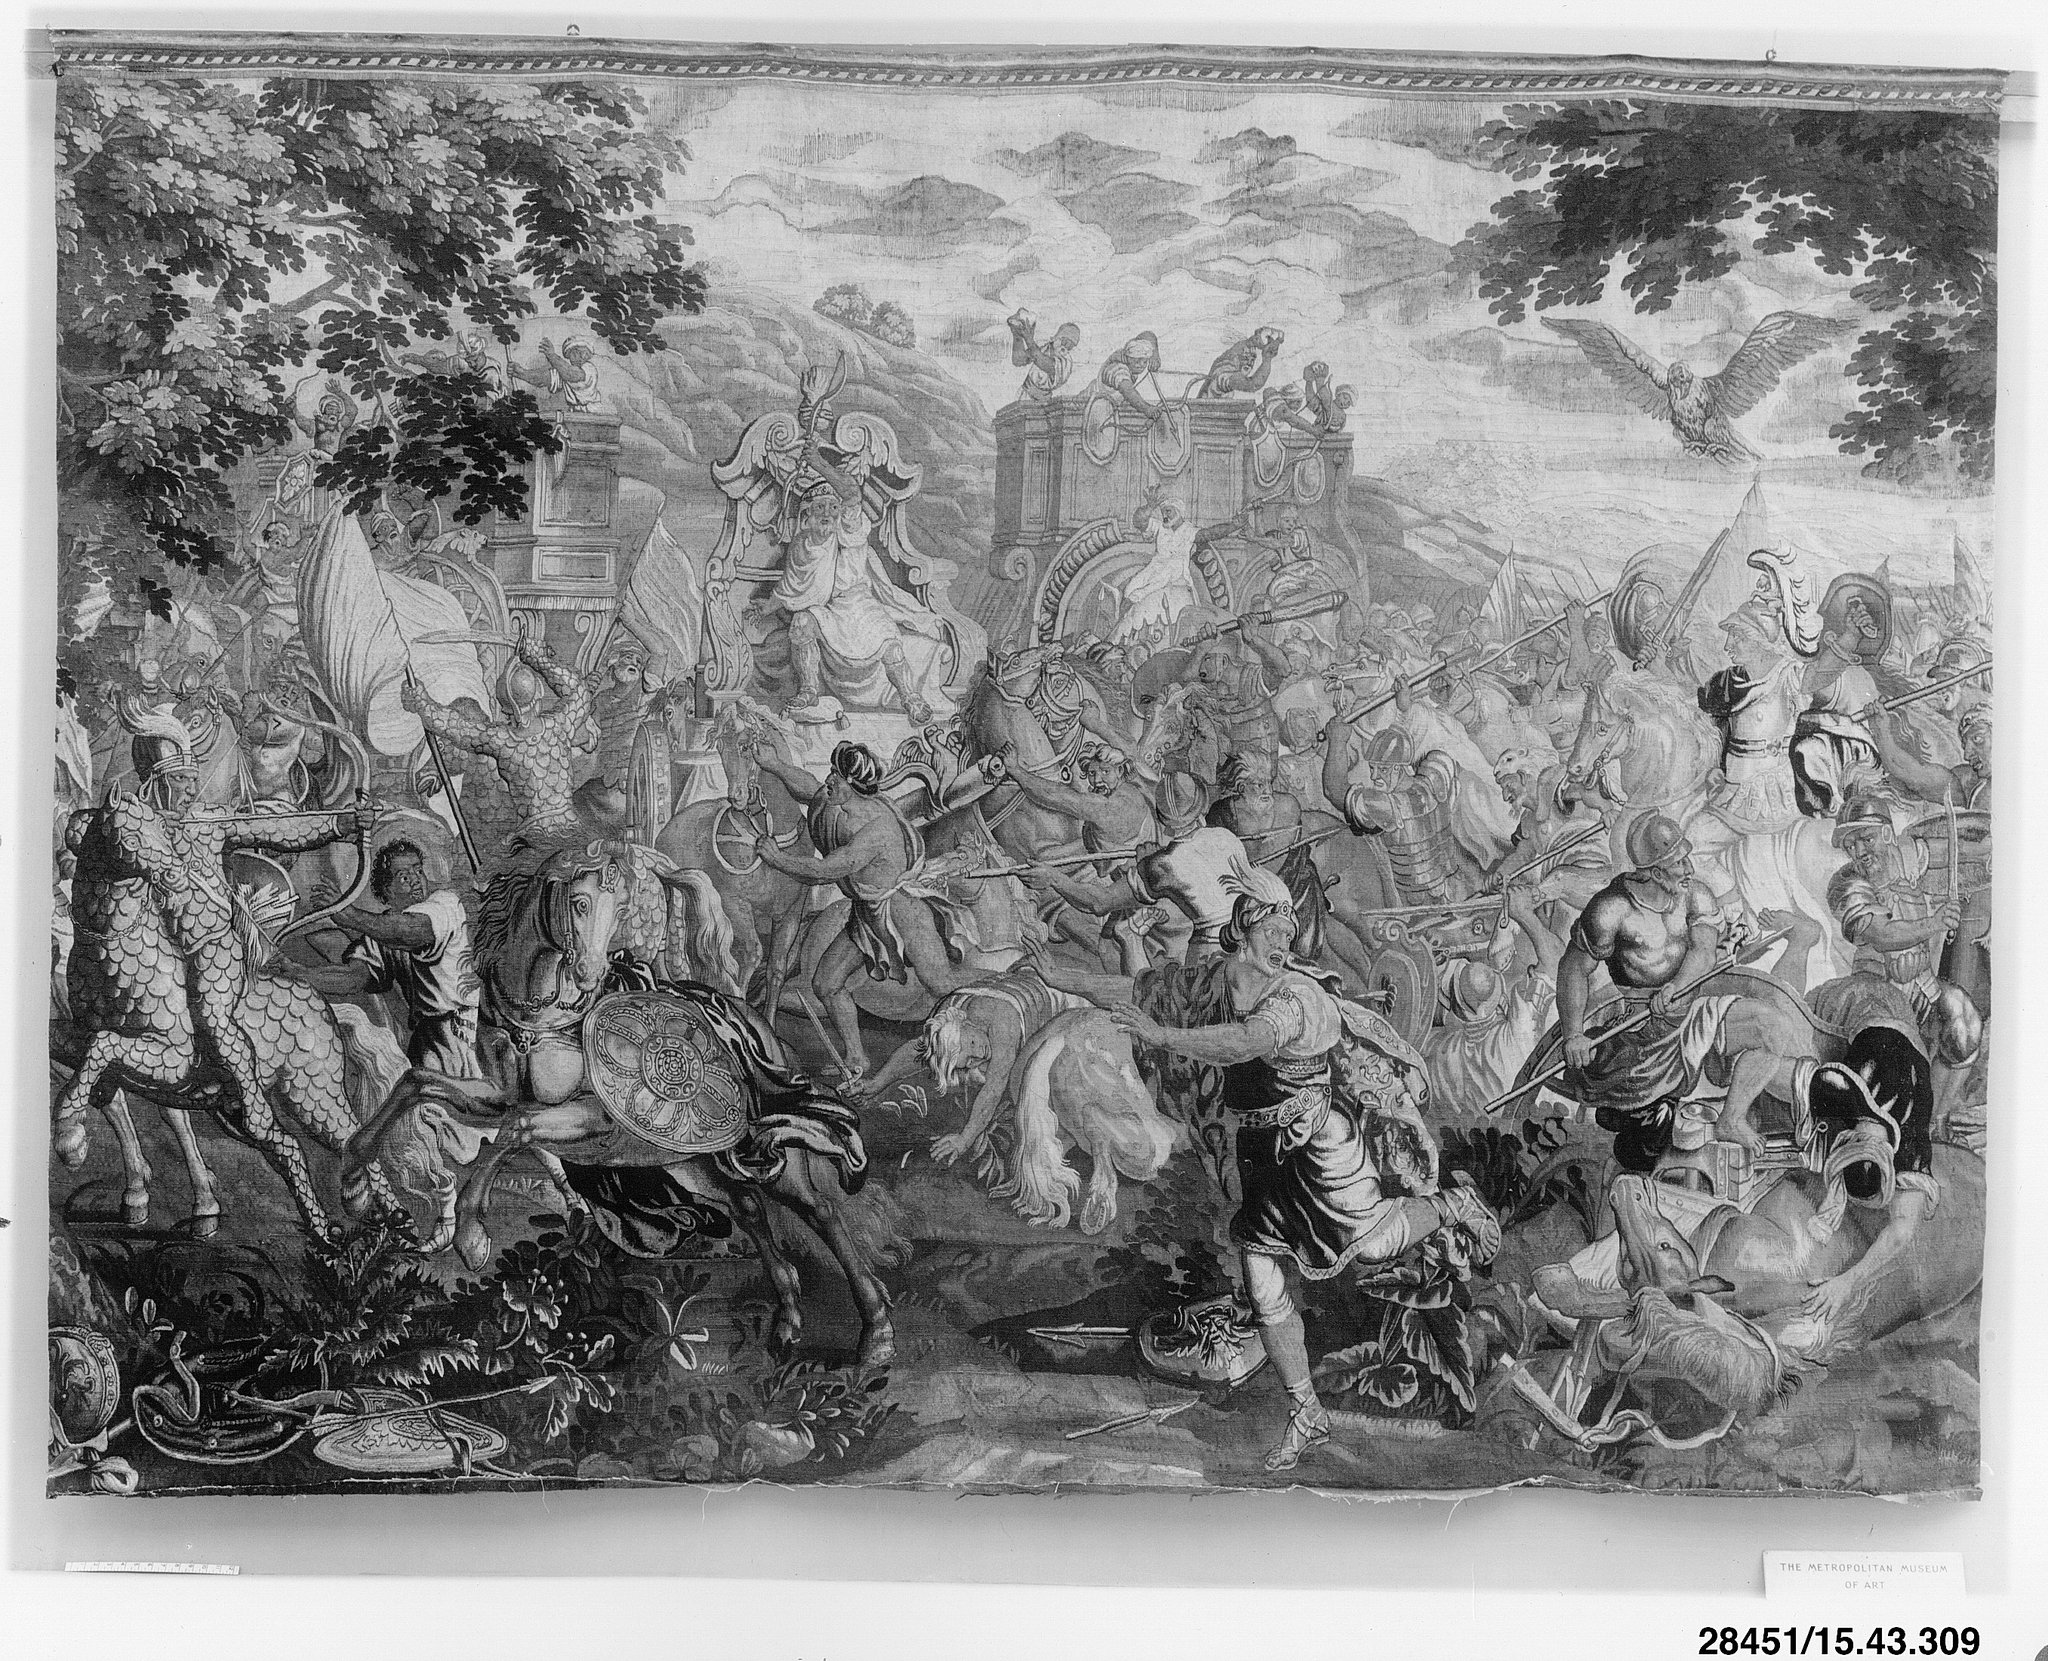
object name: tapestry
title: The Battle of Arbela from a set of The Story of Alexander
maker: charles le brun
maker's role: artist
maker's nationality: french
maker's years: 1619-1690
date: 1700-1735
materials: silk, wool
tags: birds,battles,horses